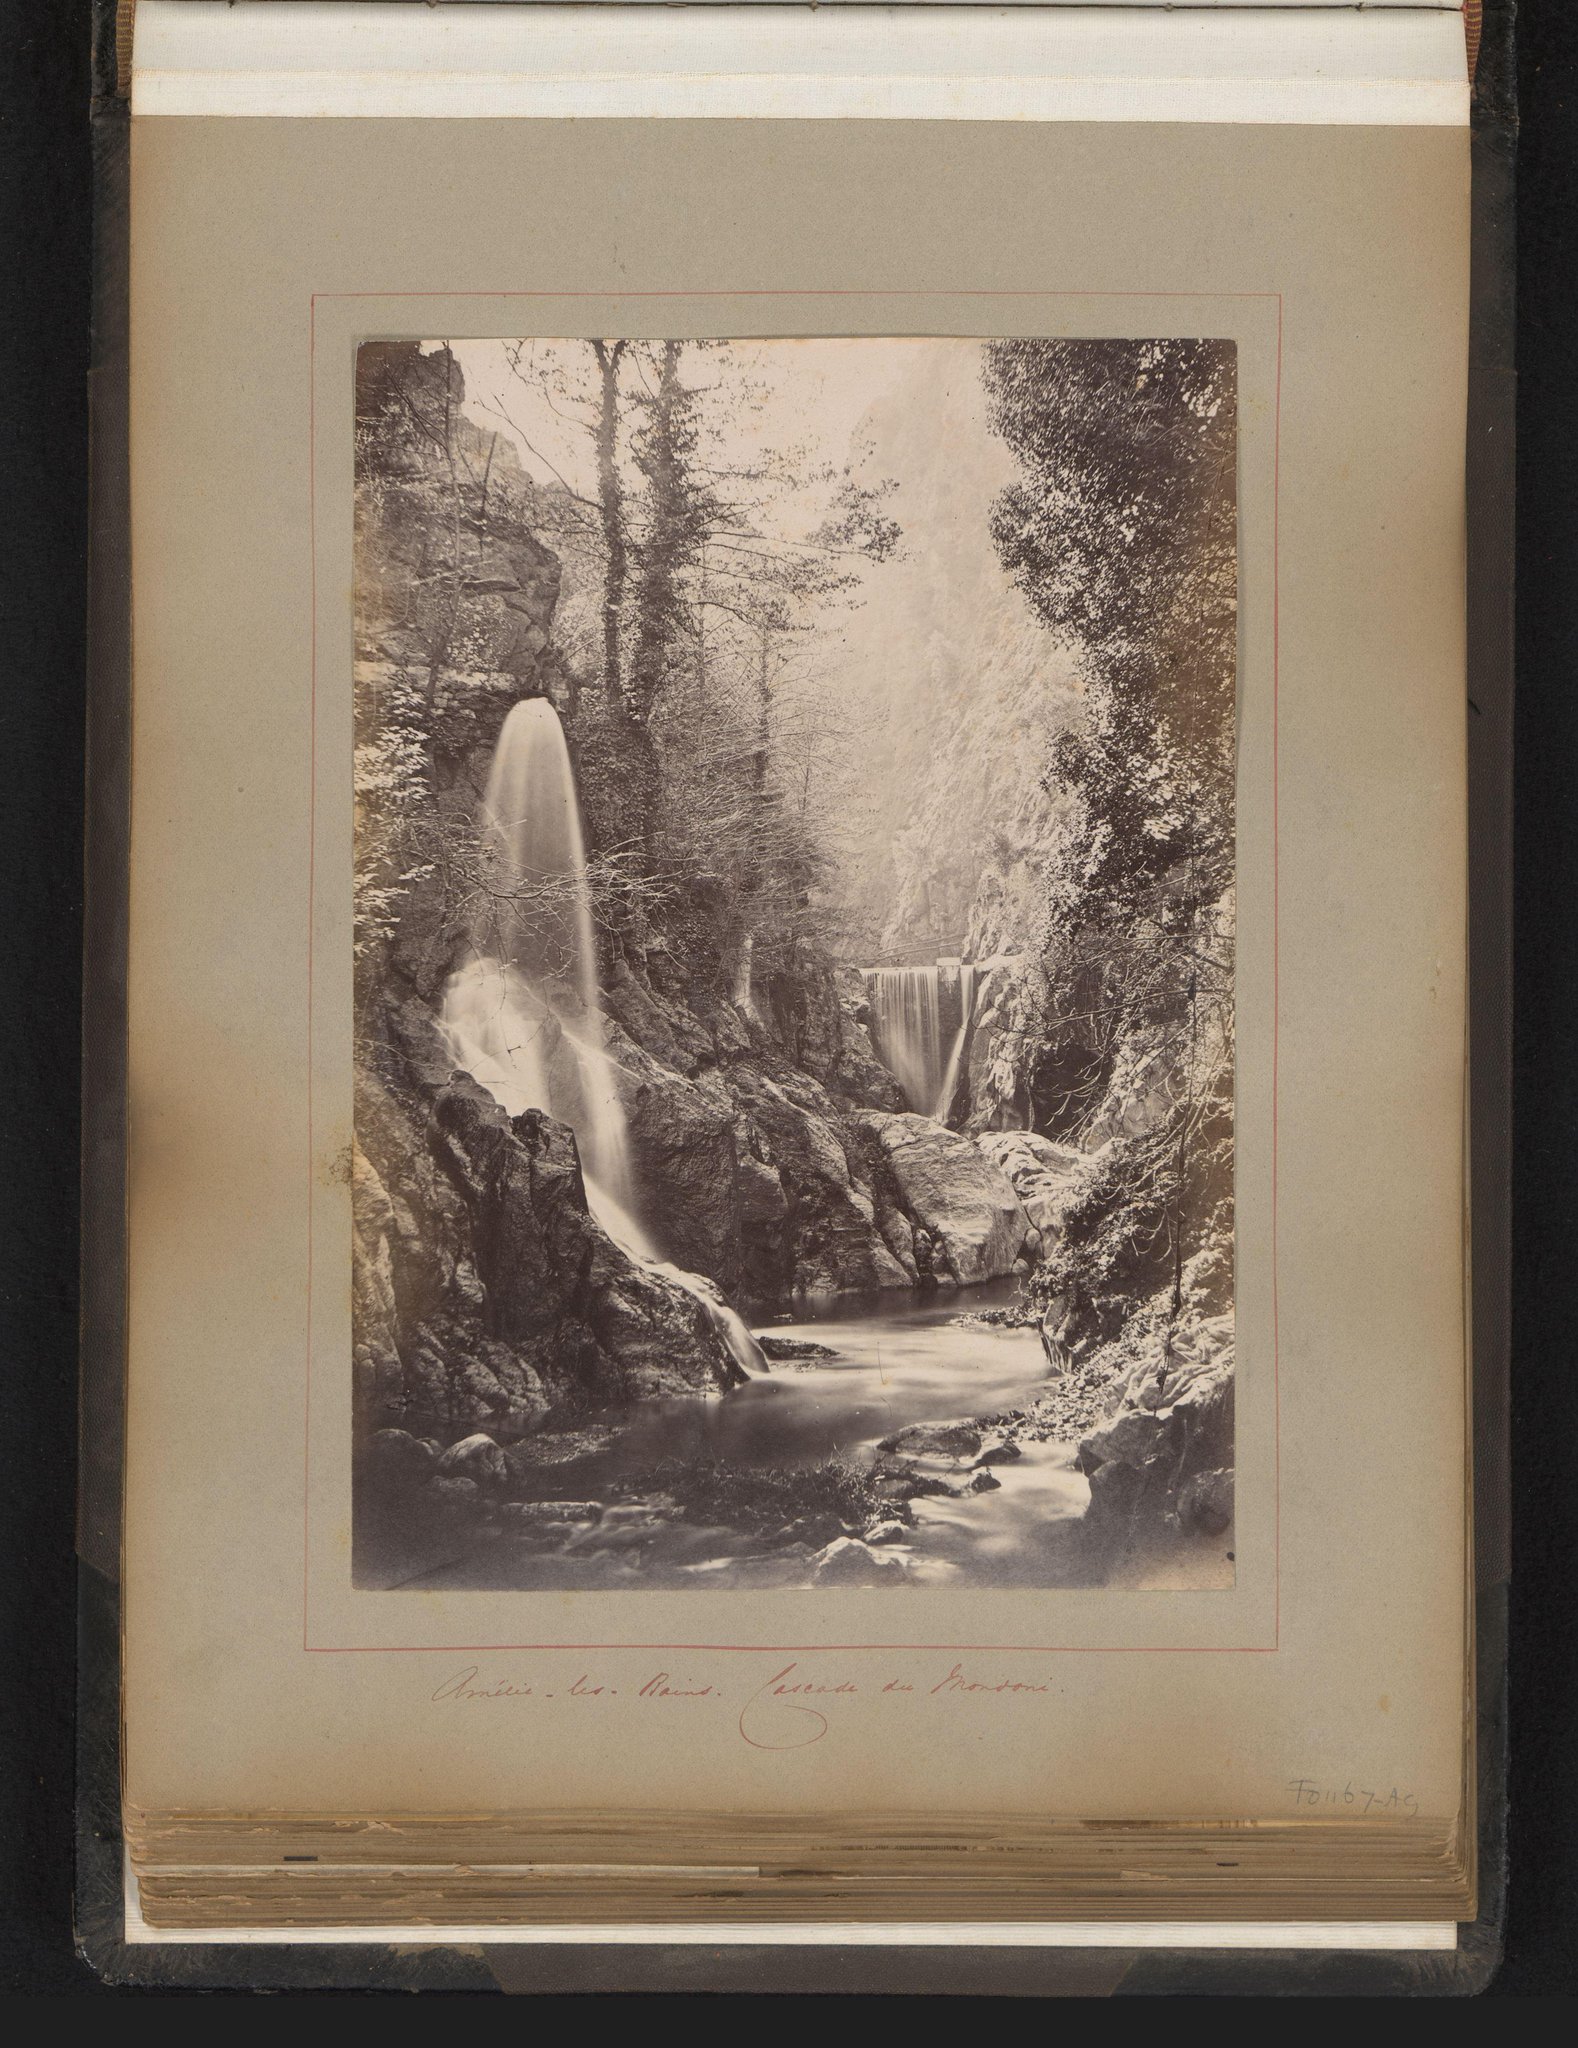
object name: album leaf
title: Mondony waterval te Amélie-les-Bains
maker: Anonymous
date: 1880-1910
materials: photographic support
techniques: albumen print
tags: trees, waterfall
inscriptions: annotation: ‘Amélie-les-Bains Cascade de Mondoni’